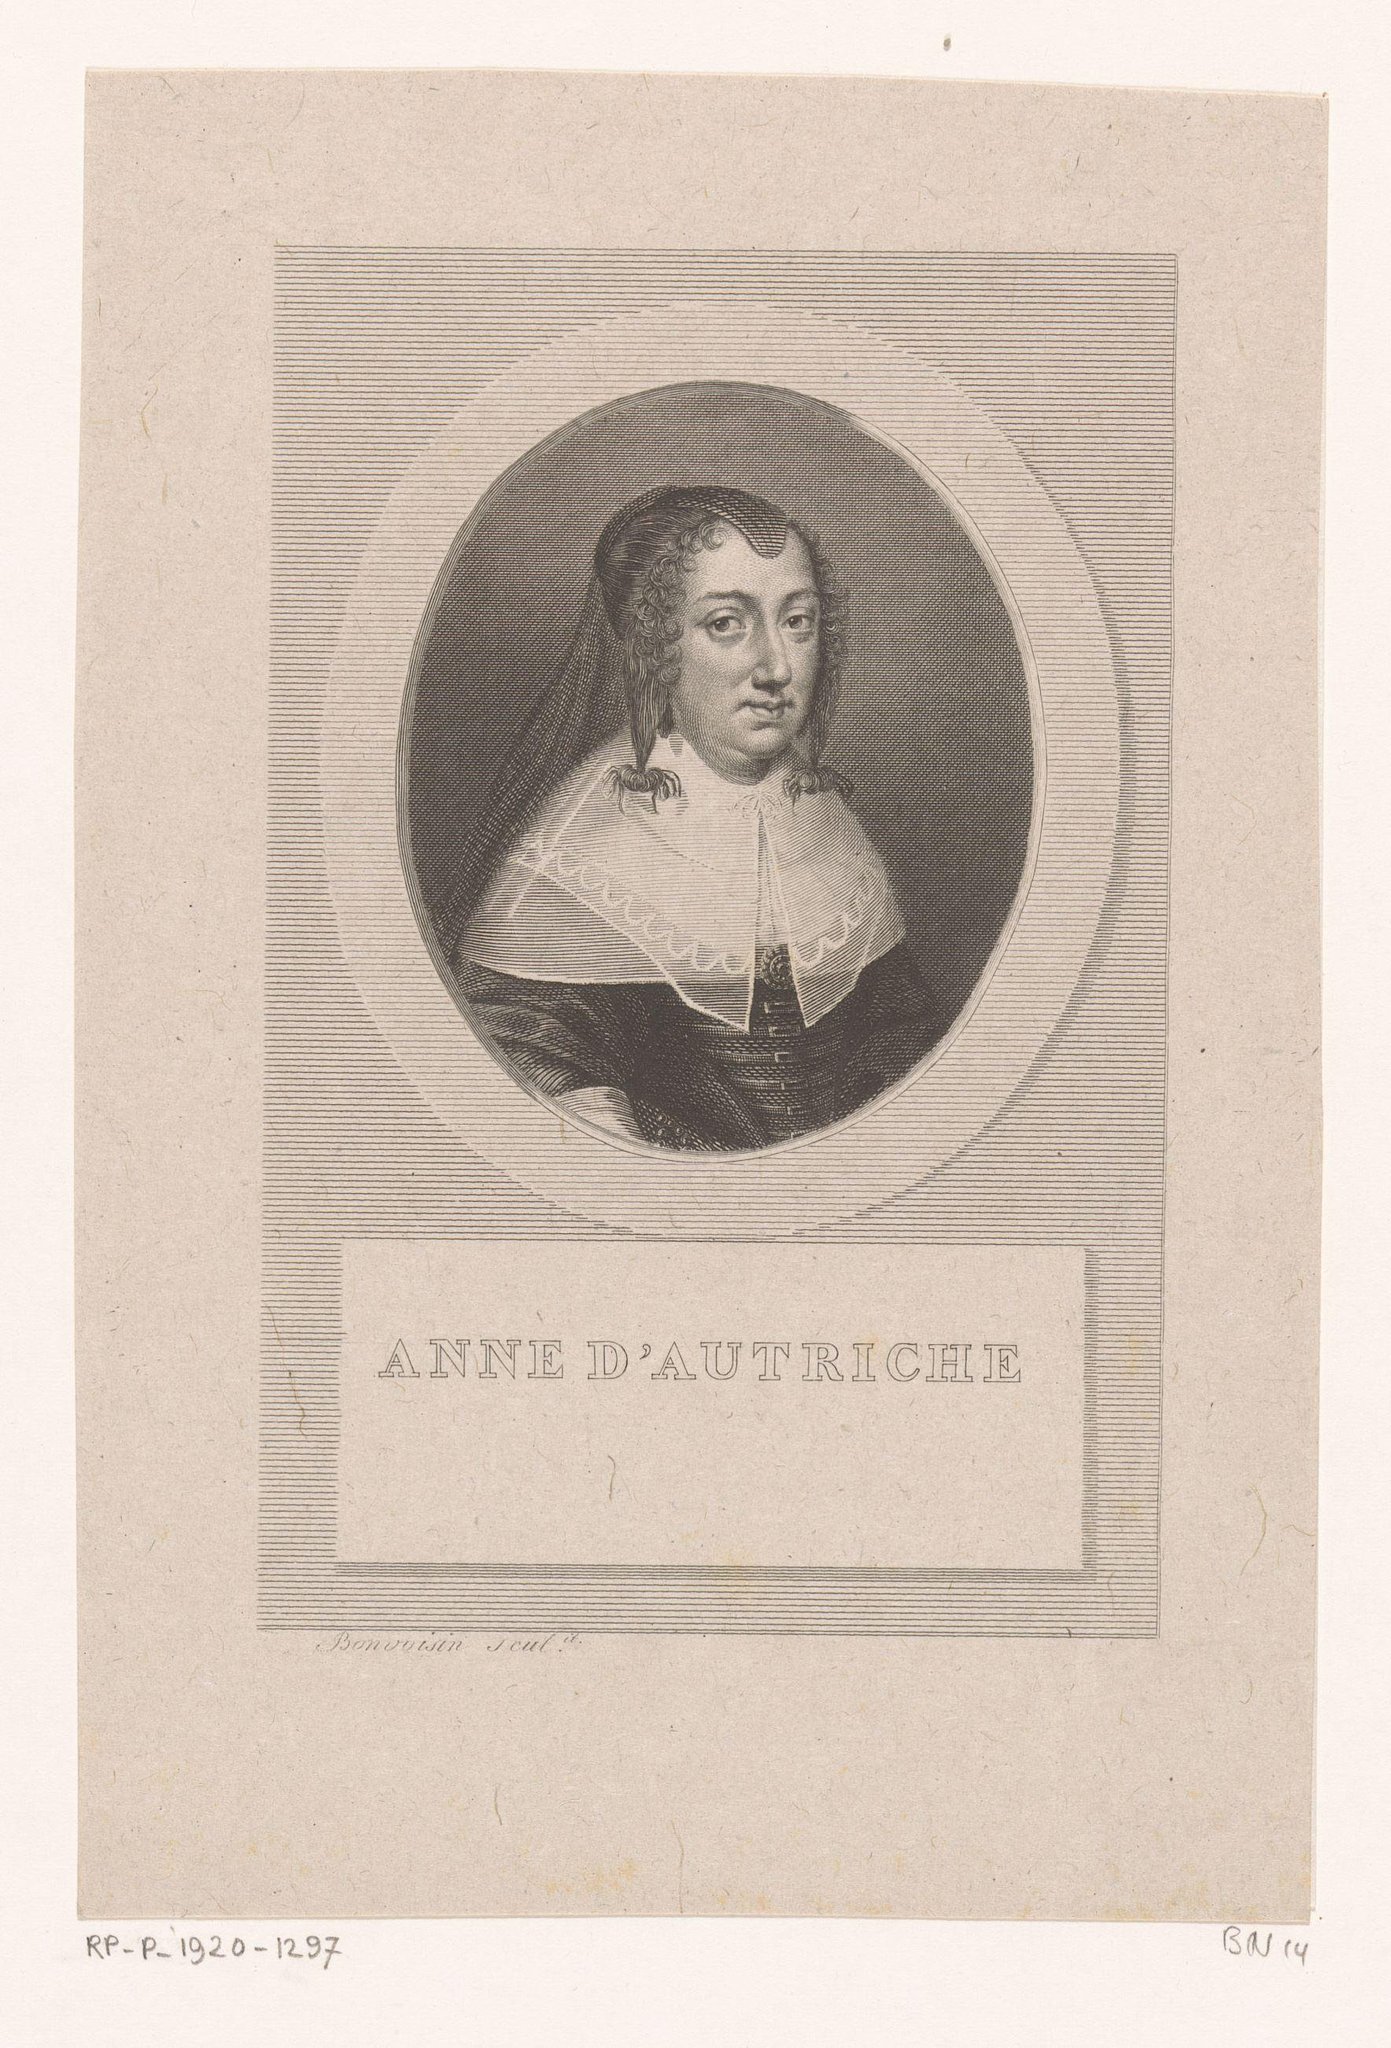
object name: print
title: Anne d'Autriche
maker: jean bonvoisin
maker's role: print maker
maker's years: 1752-1837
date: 1816-1831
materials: paper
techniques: engraving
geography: paris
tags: paris, anna van oostenrijk (koningin van frankrijk), historical persons, queen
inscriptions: collector's mark: Lugt 2228